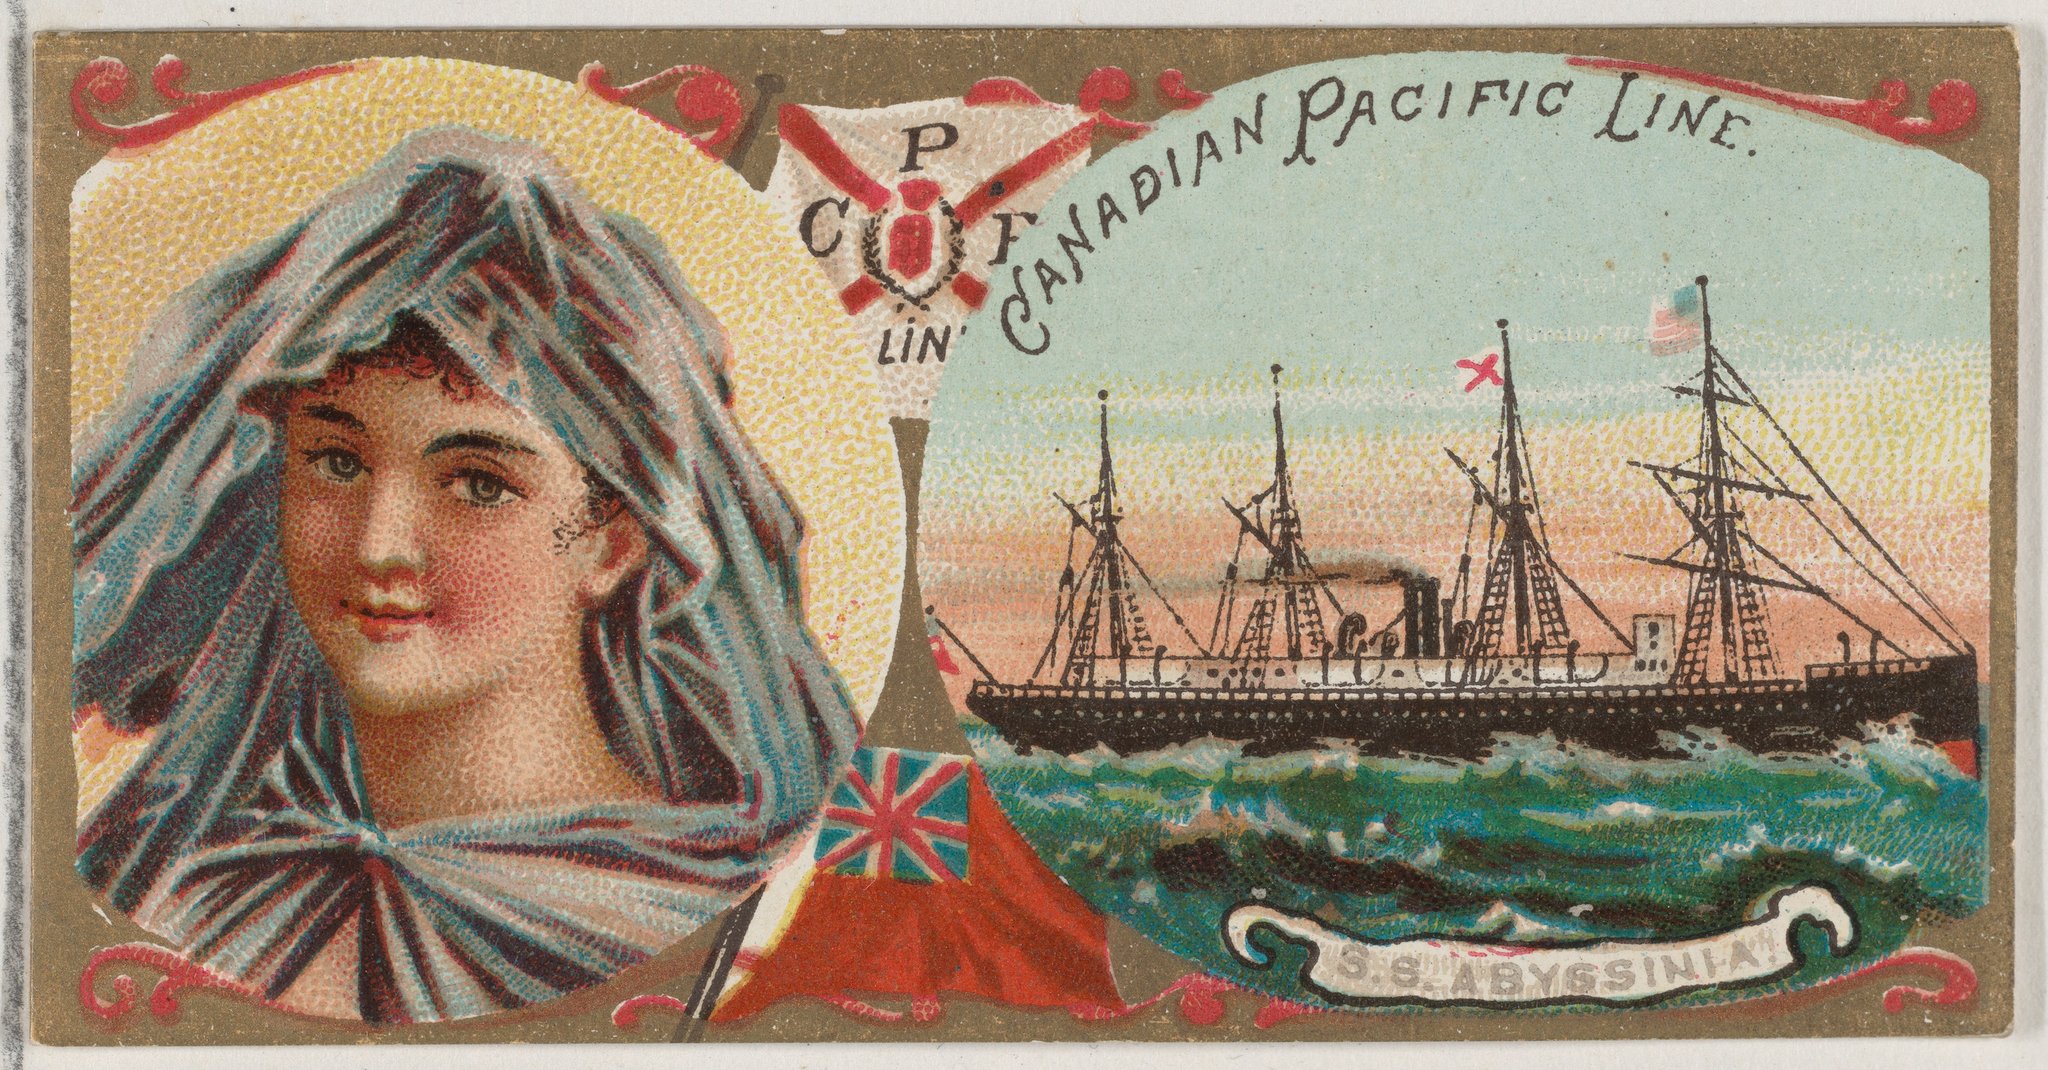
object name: print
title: Steamship Abyssinia, Canadian Pacific Line, from the Ocean and River Steamers series (N83) for Duke brand cigarettes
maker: w. duke, sons & co.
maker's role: publisher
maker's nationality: american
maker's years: 1870-1920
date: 1887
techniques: color lithograph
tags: women,ships